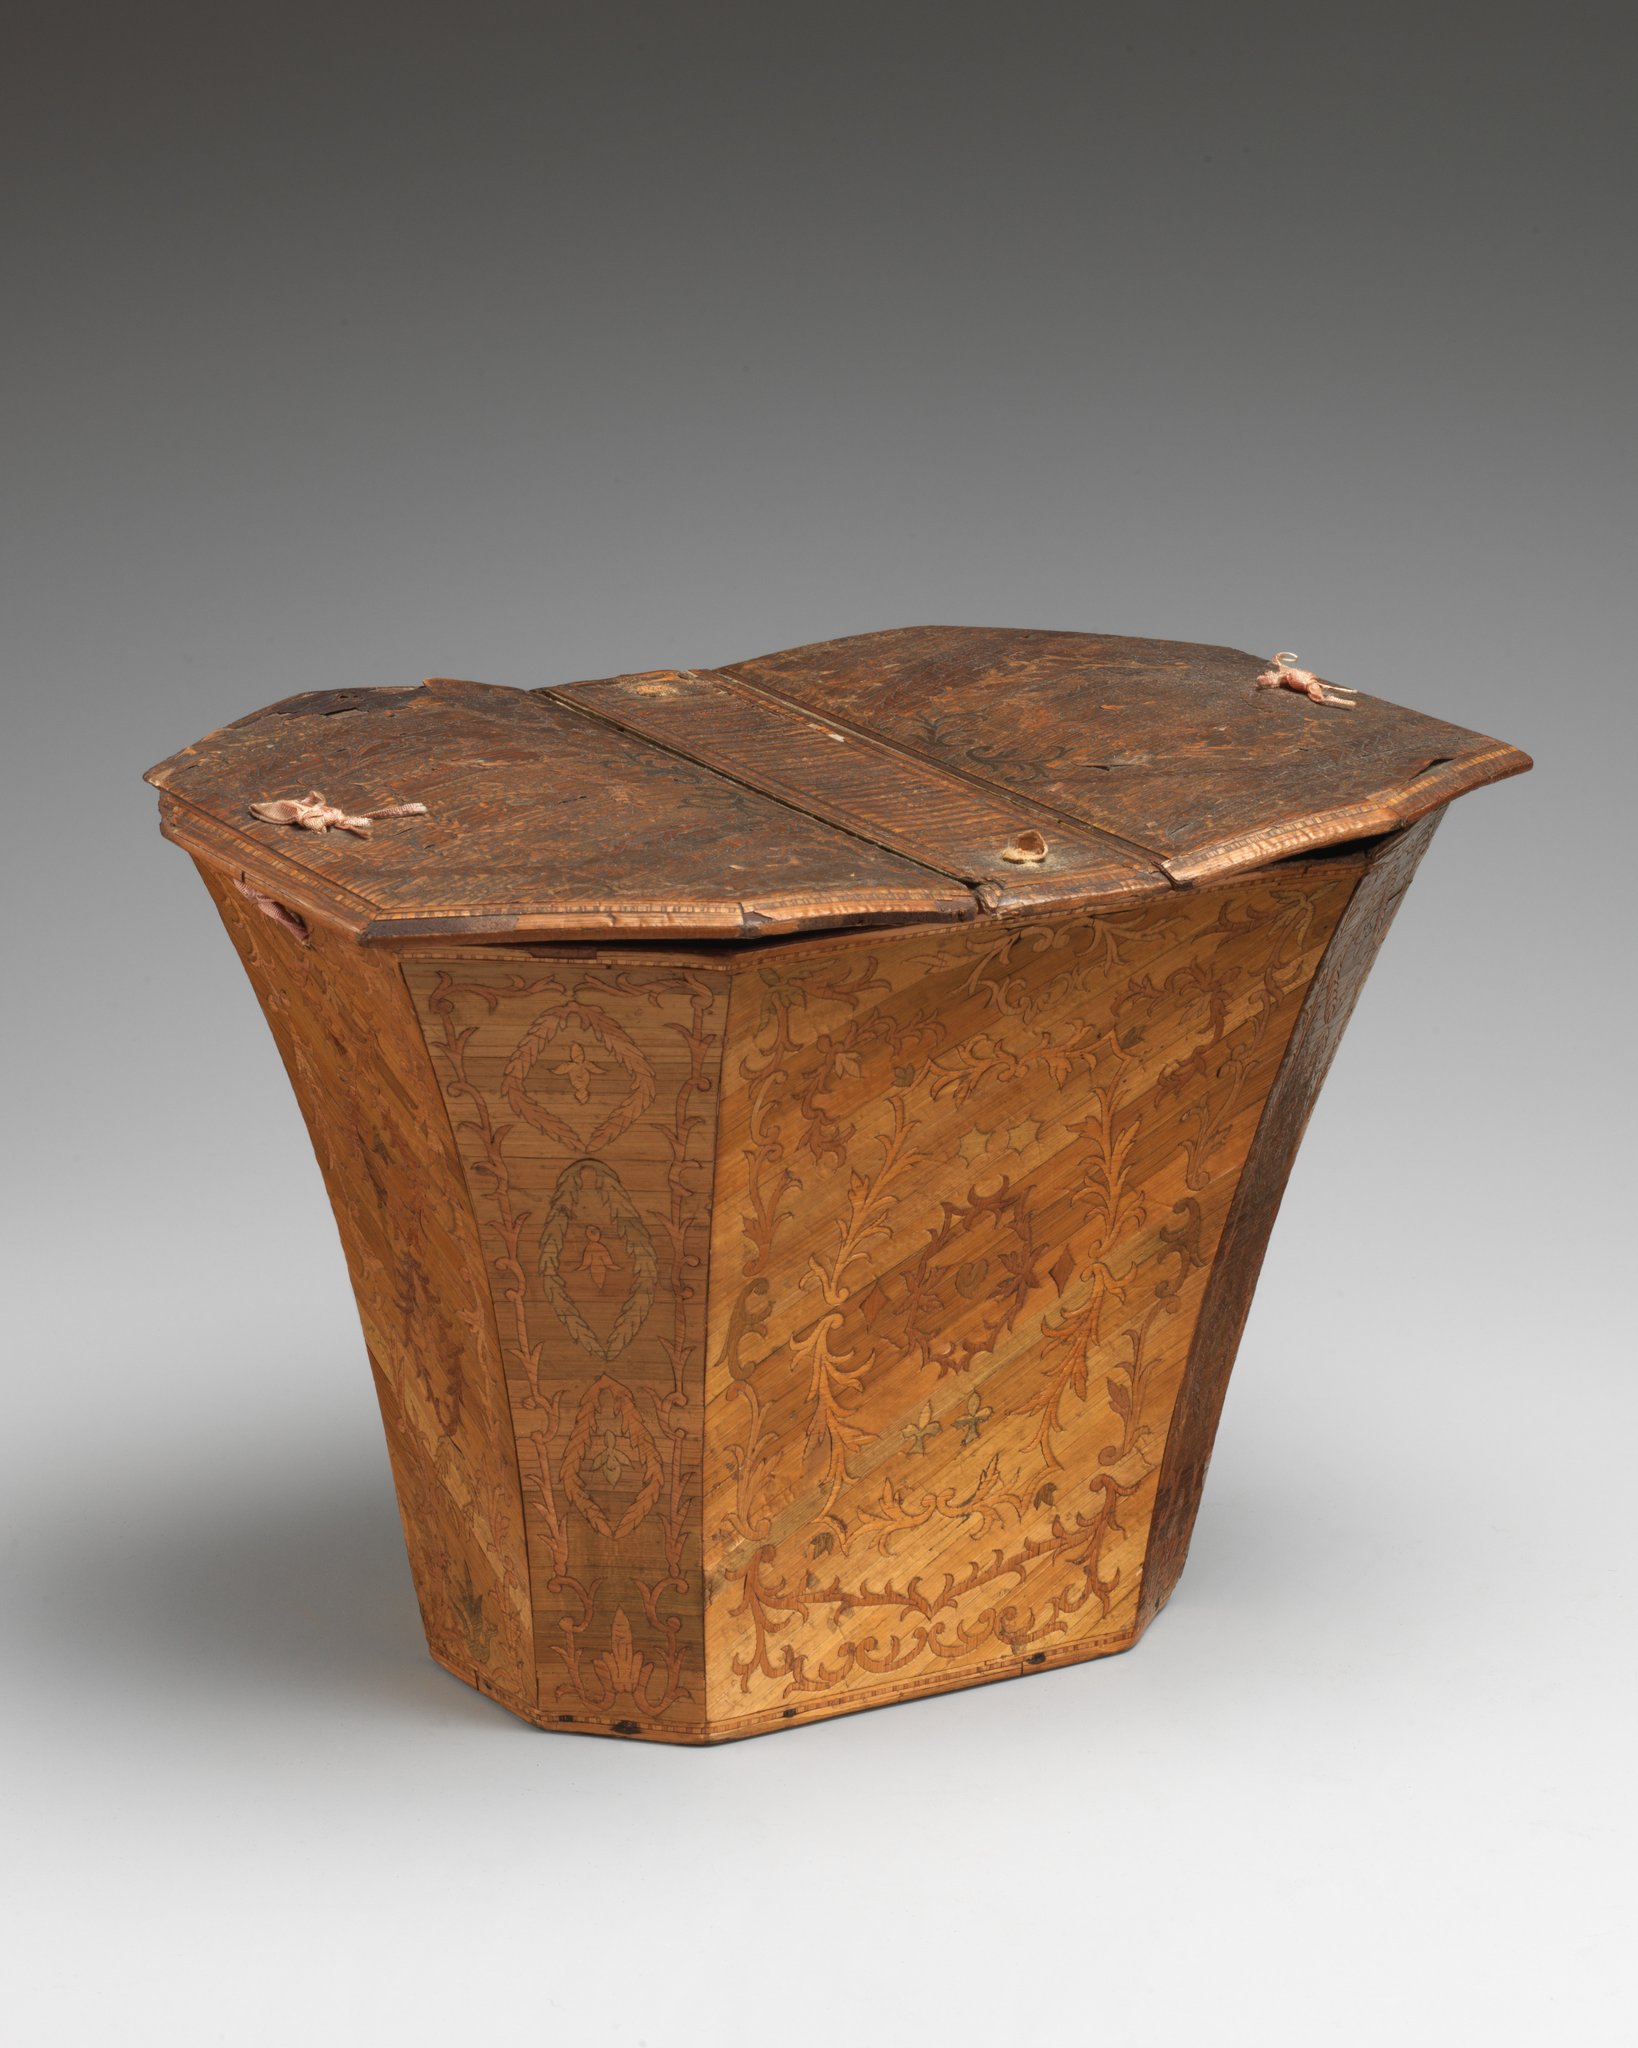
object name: basket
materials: paper, fiber, wood